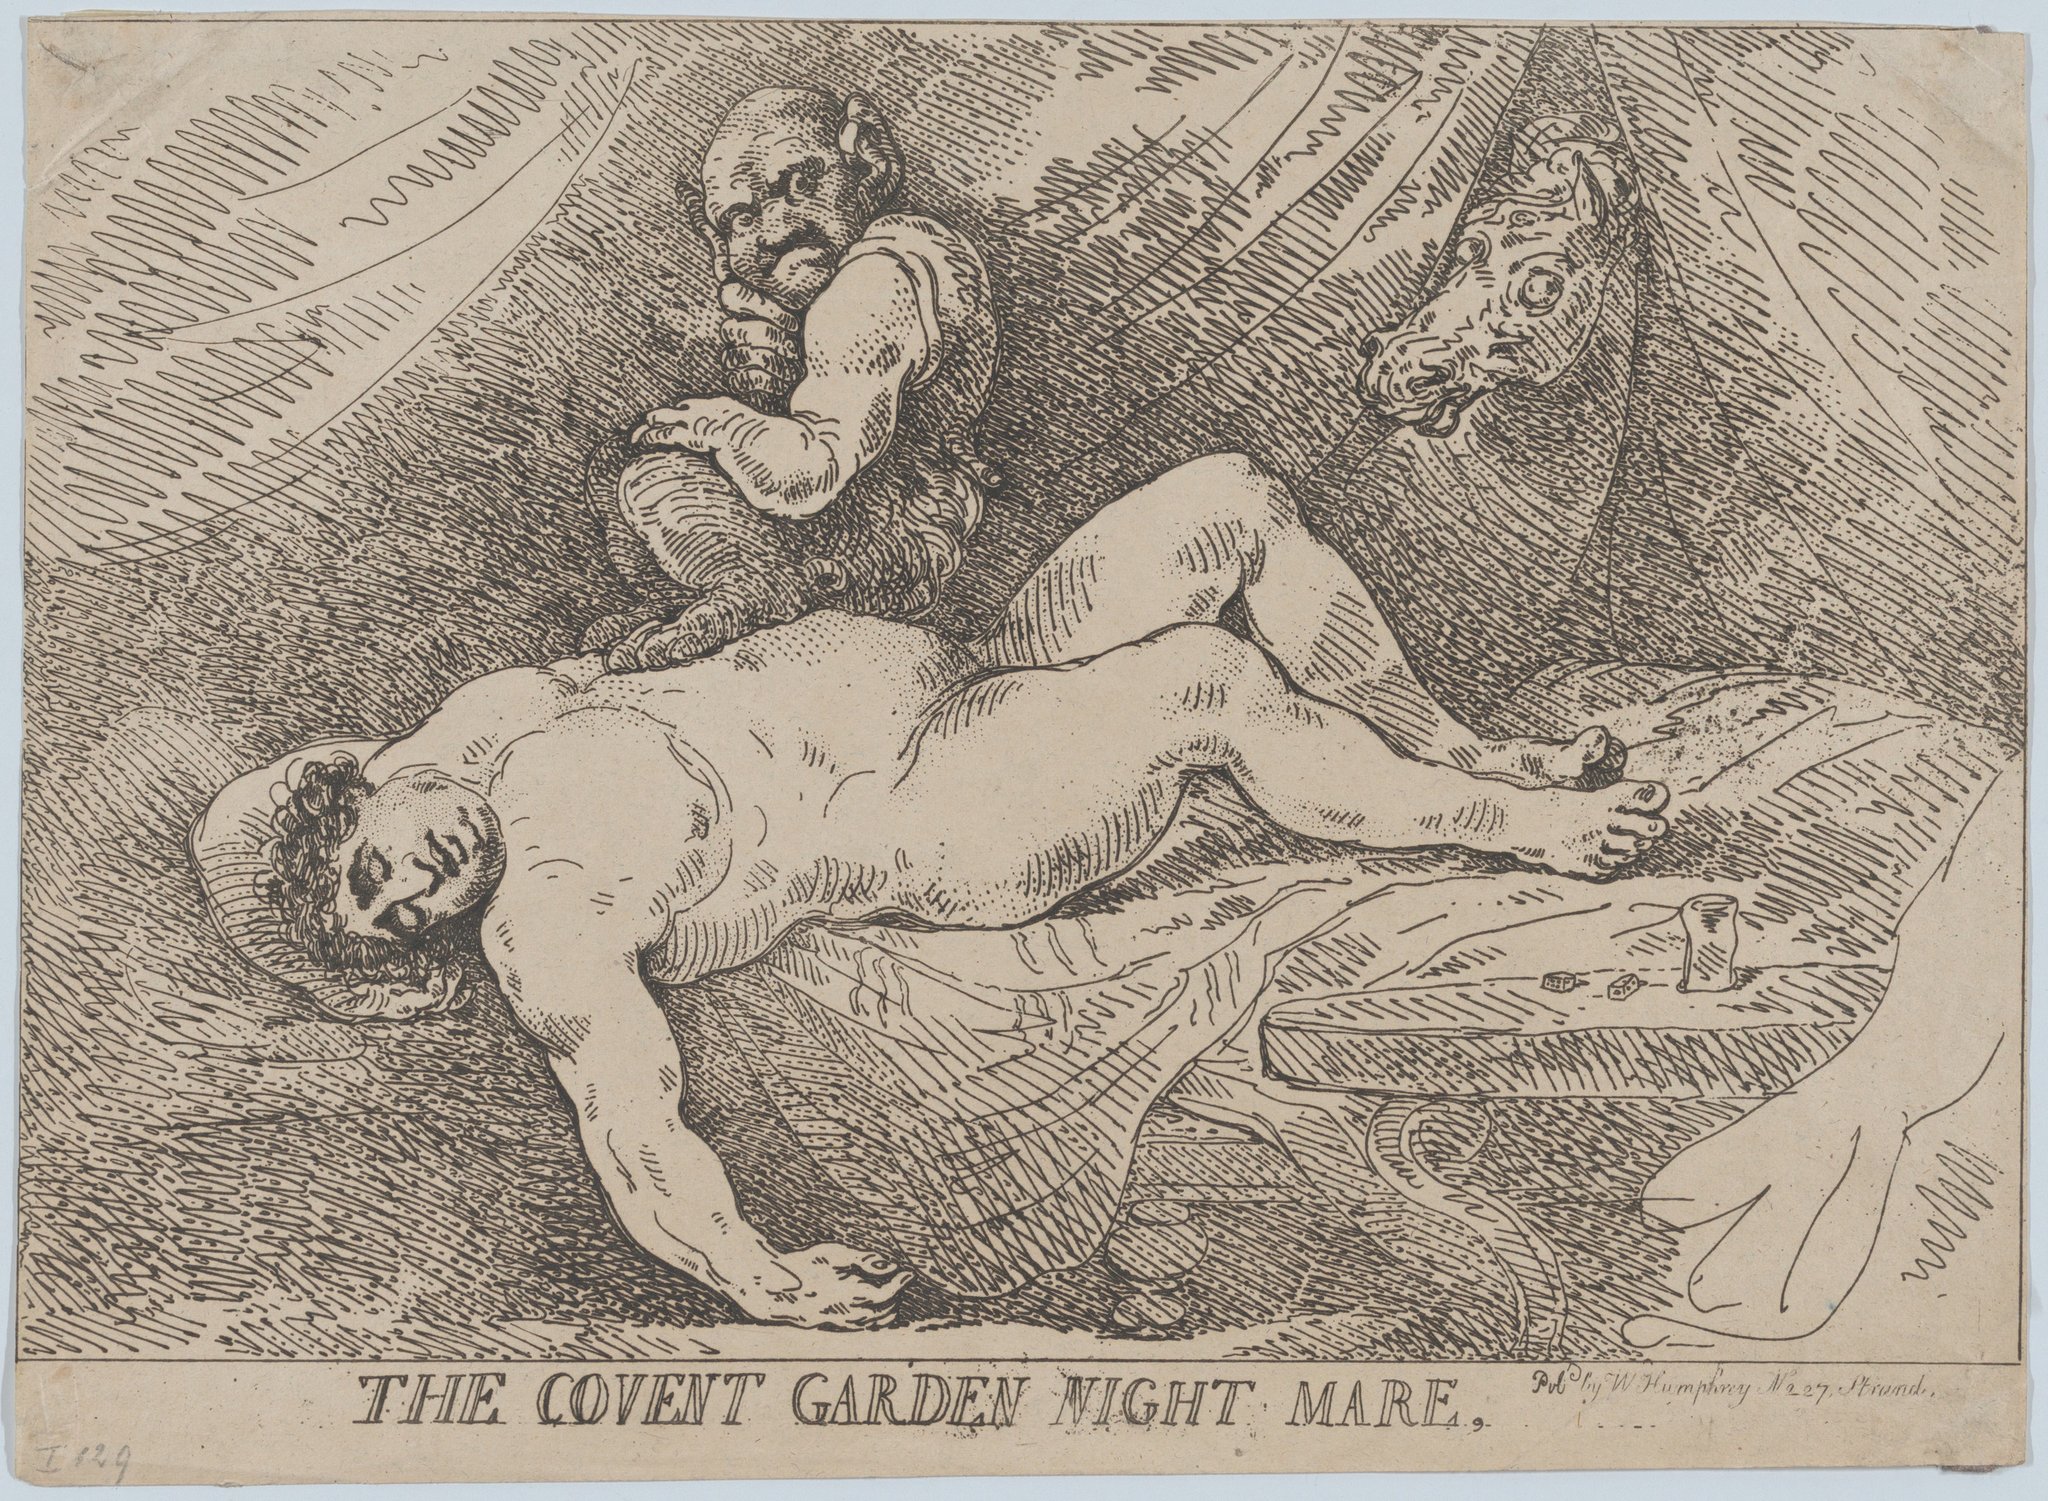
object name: print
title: The Covent Garden Night Mare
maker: thomas rowlandson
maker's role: artist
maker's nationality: british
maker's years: 1757-1827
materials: ink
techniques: etching, printing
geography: london